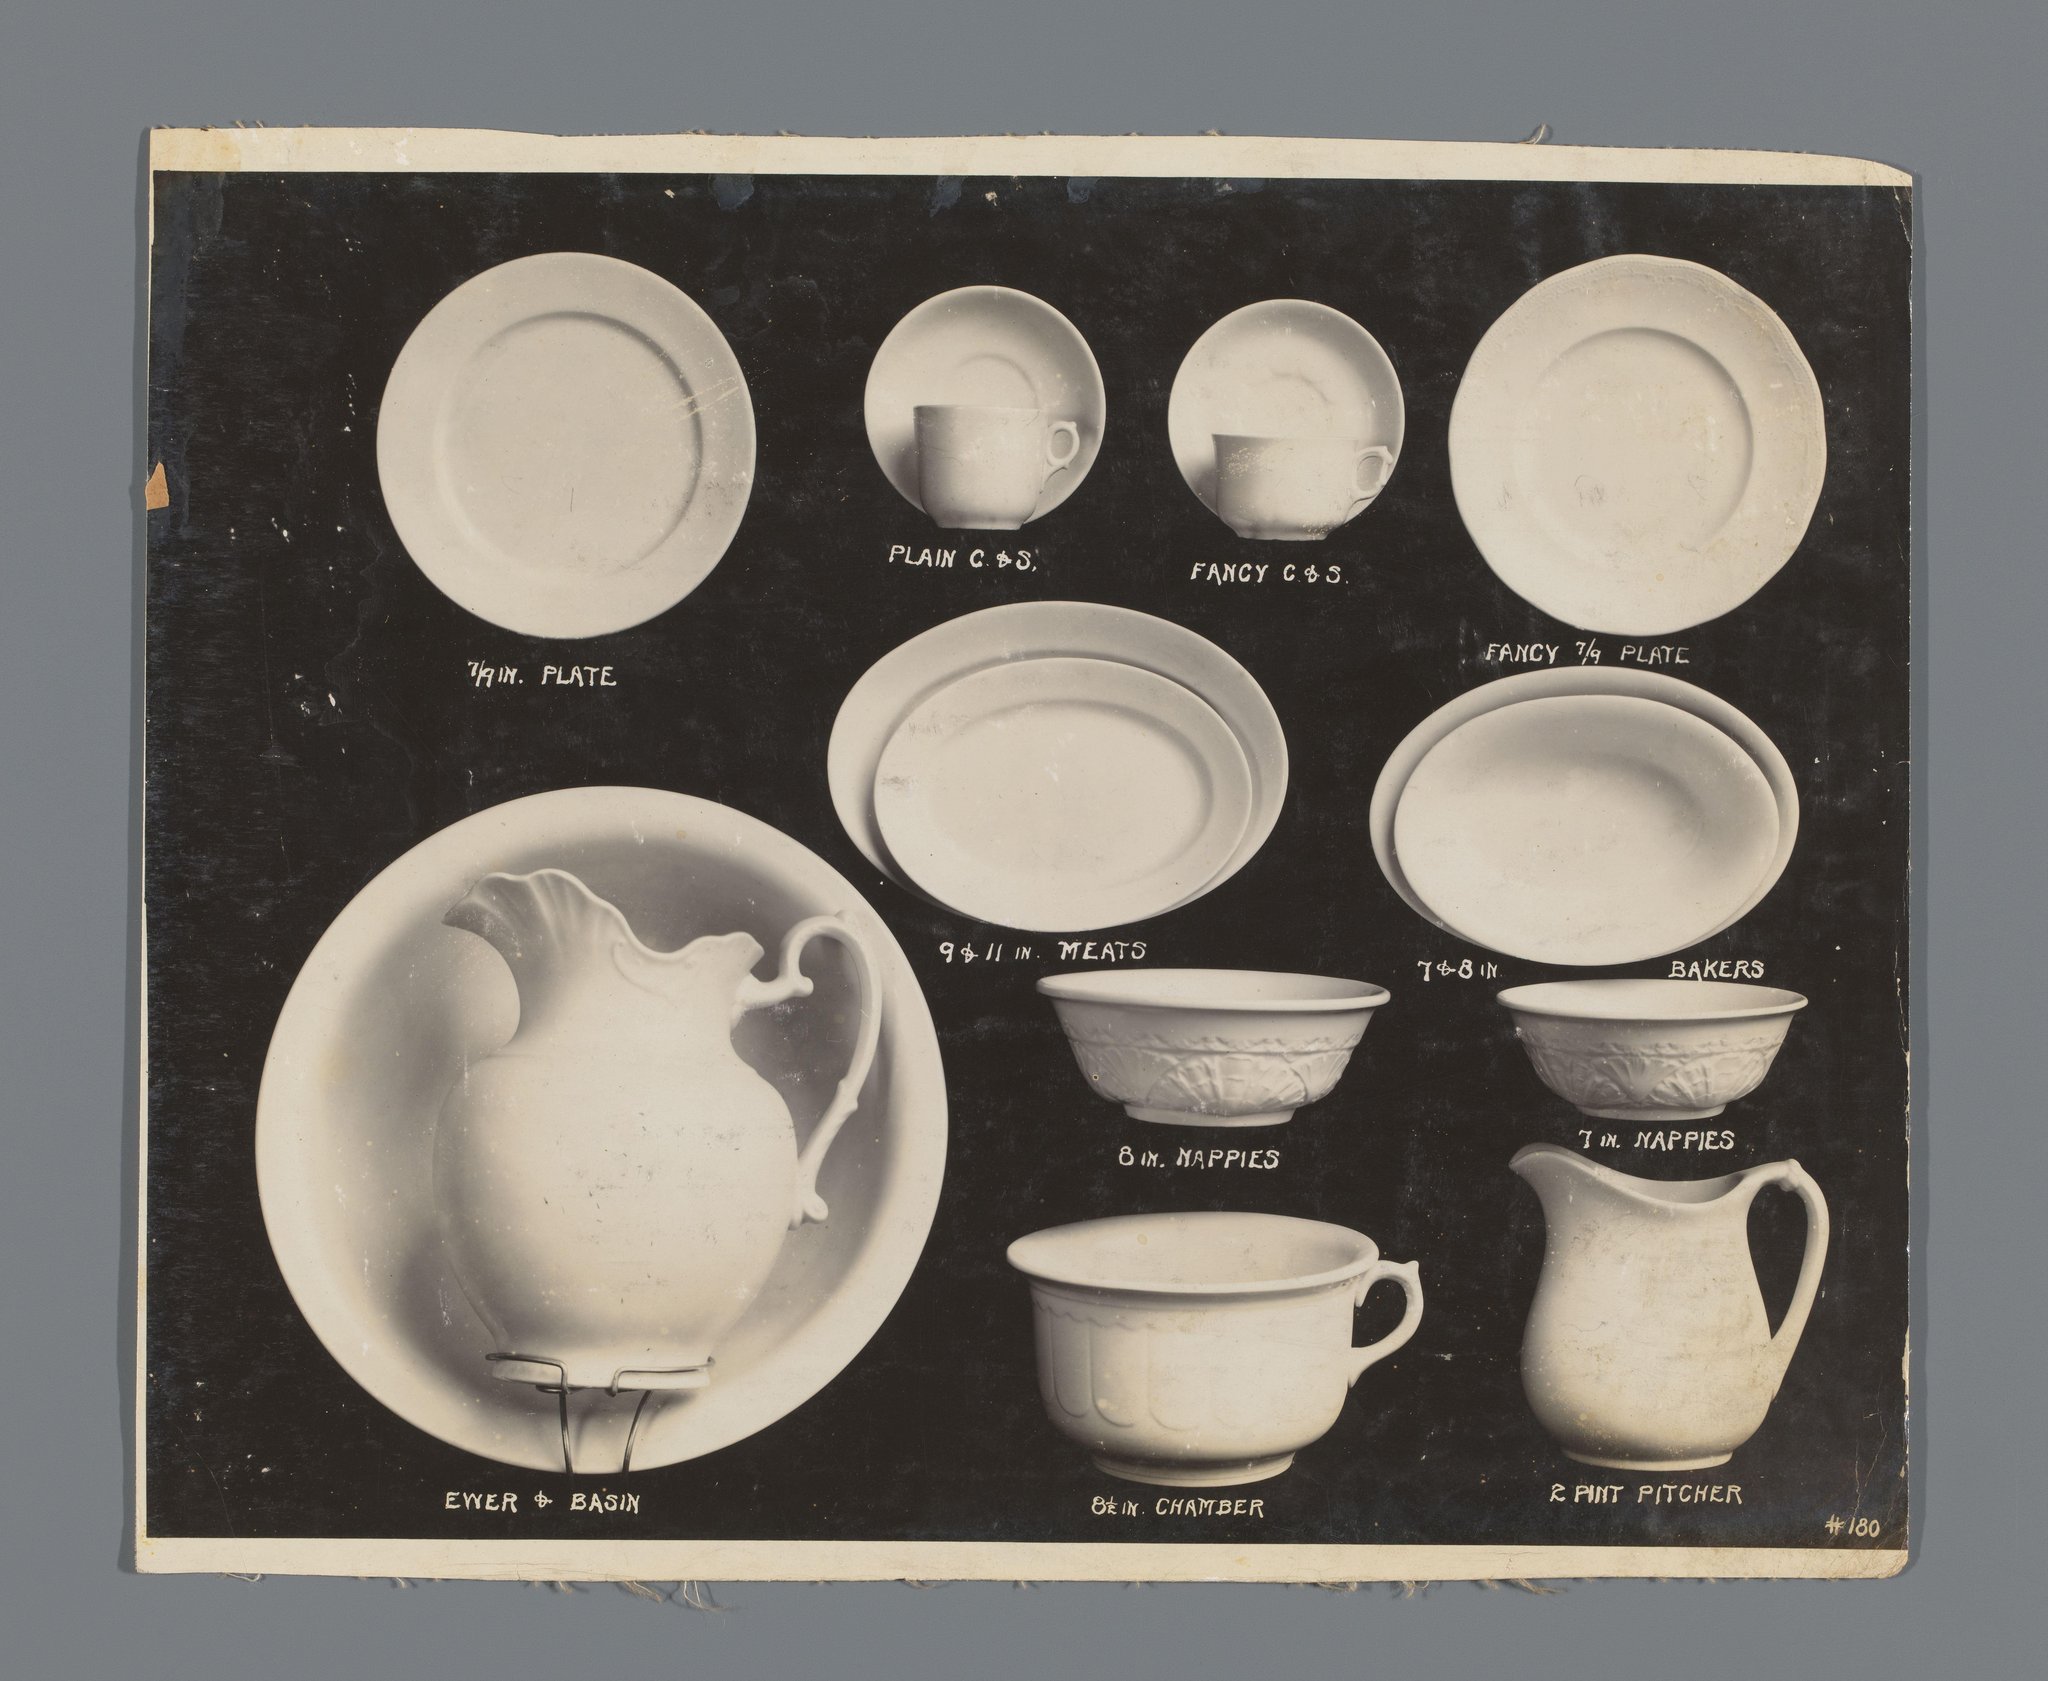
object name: photograph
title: Reclamefoto met serviezen en keukengerei van de firma C. Read & Co., Baltimore, Maryland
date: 1920-1930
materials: paper, textile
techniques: photography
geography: united states